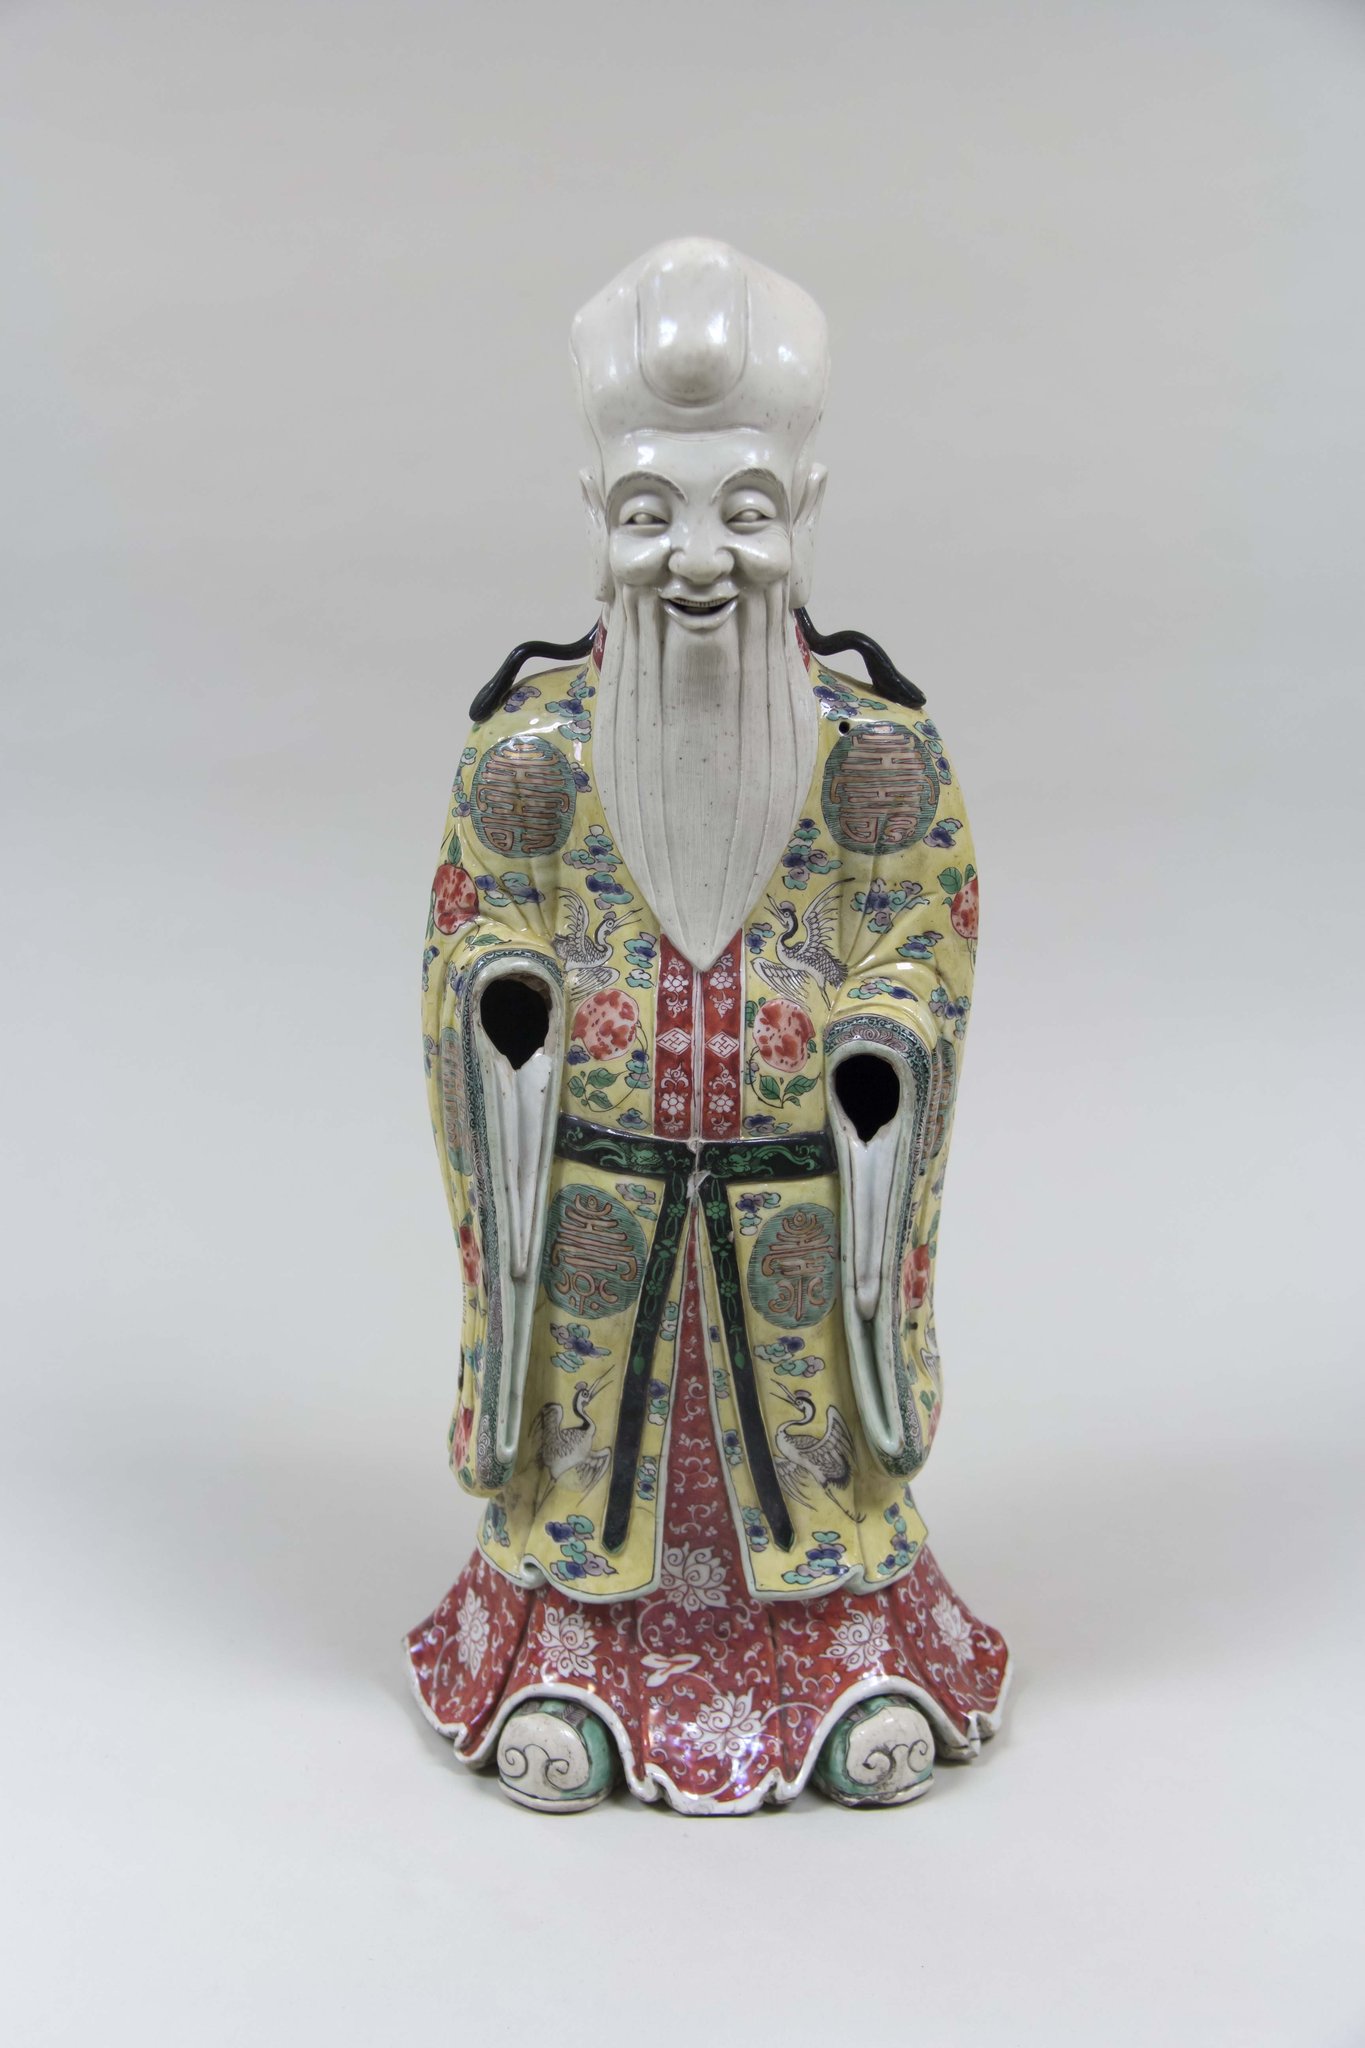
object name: figure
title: God of Longevity (Shoulao)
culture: chinese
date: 1667-1733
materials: biscuit, enamel, porcelain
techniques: painting, polychrome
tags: birds,men,flowers